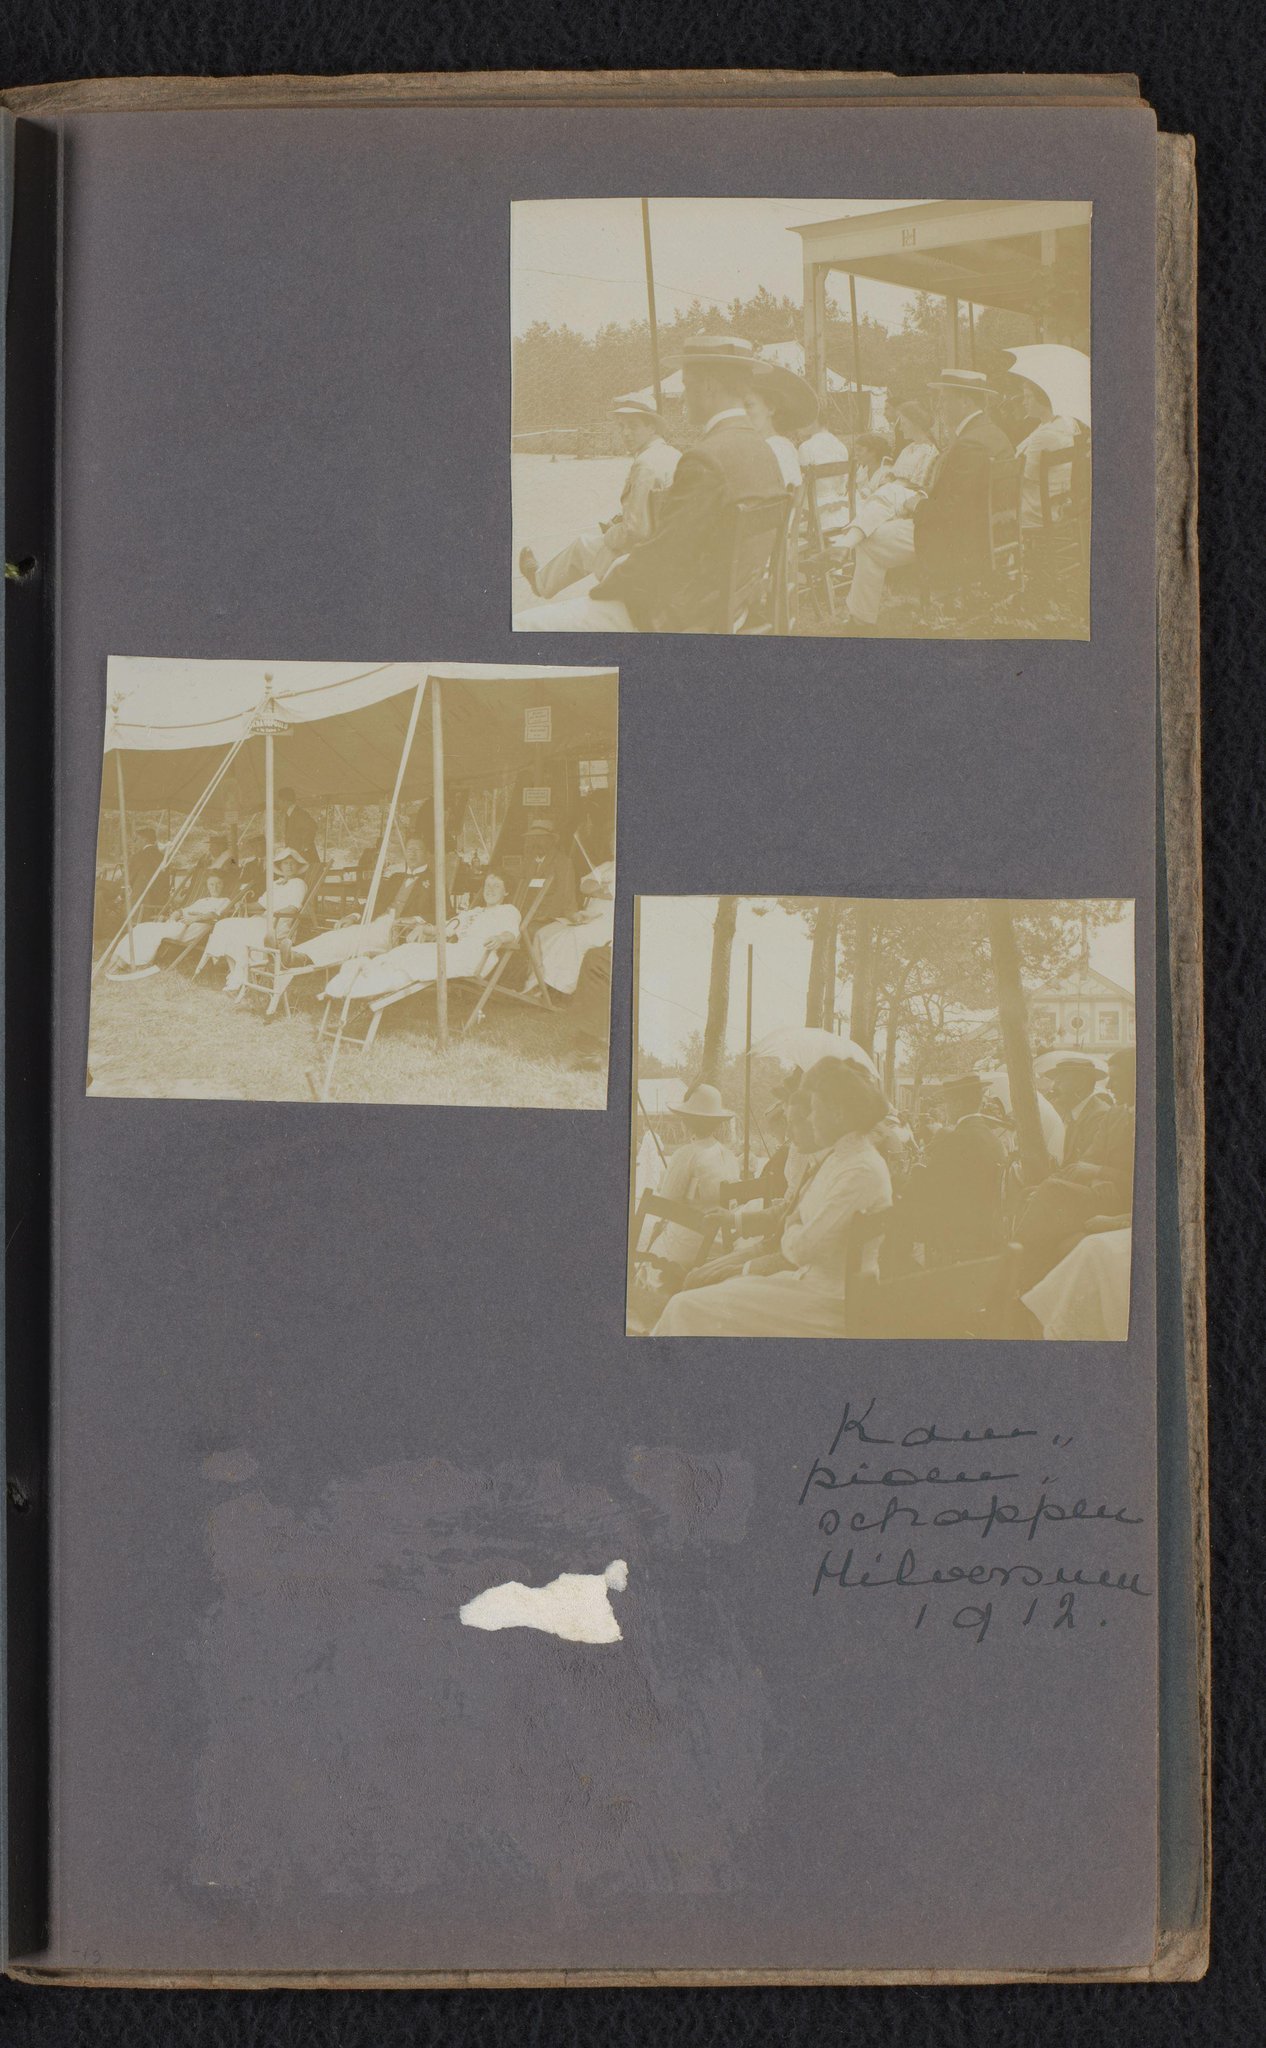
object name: album leaf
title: Publiek tijdens een tenniswedstrijd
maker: carolina frederika onnen (lien/loen)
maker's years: 1896-1983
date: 1912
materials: paper, cardboard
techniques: collodion silver print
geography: hilversum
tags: tennis, lawn-tennis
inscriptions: inscription: ‘Kam "/ pioen "/ schappen’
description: Deze foto's zijn onderdeel van een album.